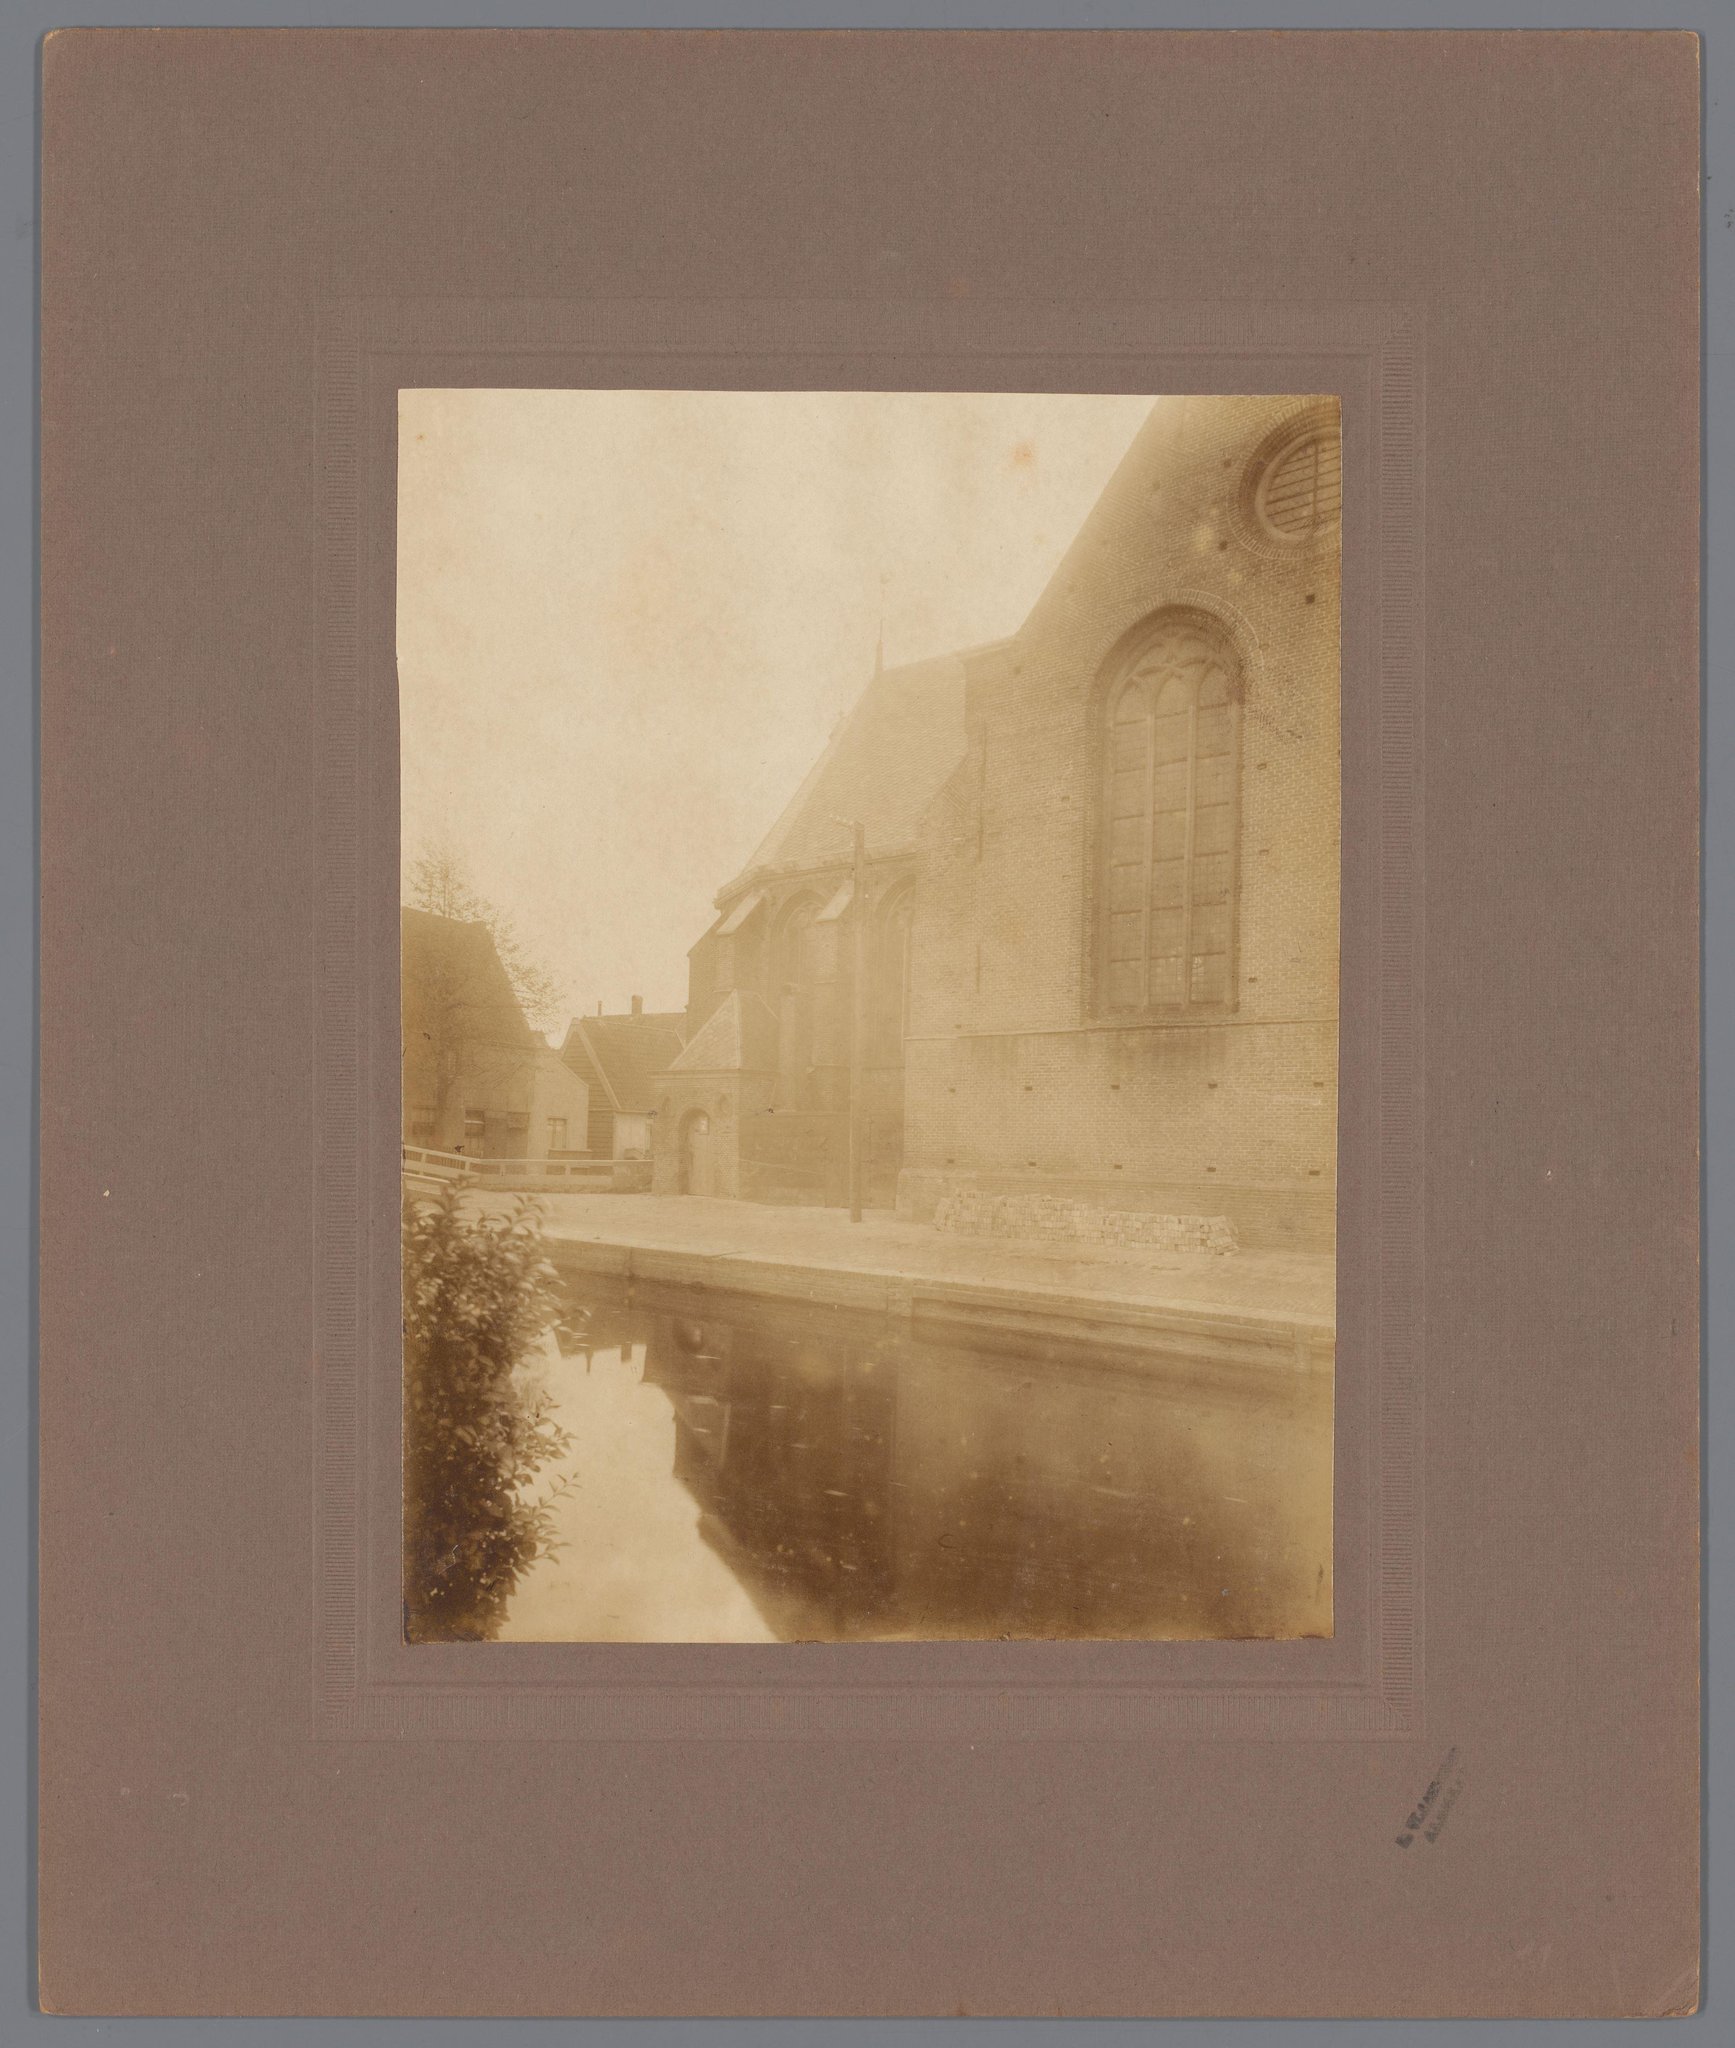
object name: photograph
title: Aanzicht op Nederlands Hervormde Kerk in De Rijp, Noord-Holland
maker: leonard vlaanderen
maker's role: fotograaf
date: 1921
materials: cardboard, paper, photographic support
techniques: gelatin silver print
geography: alkmaar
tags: de rijp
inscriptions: stamp: ‘L. VLAANDEREN//ALKMAAR’, annotation: ‘De Rijp 1921’, date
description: Aanzicht op Nederlands Hervormde Kerk in De Rijp, Noord-Holland.